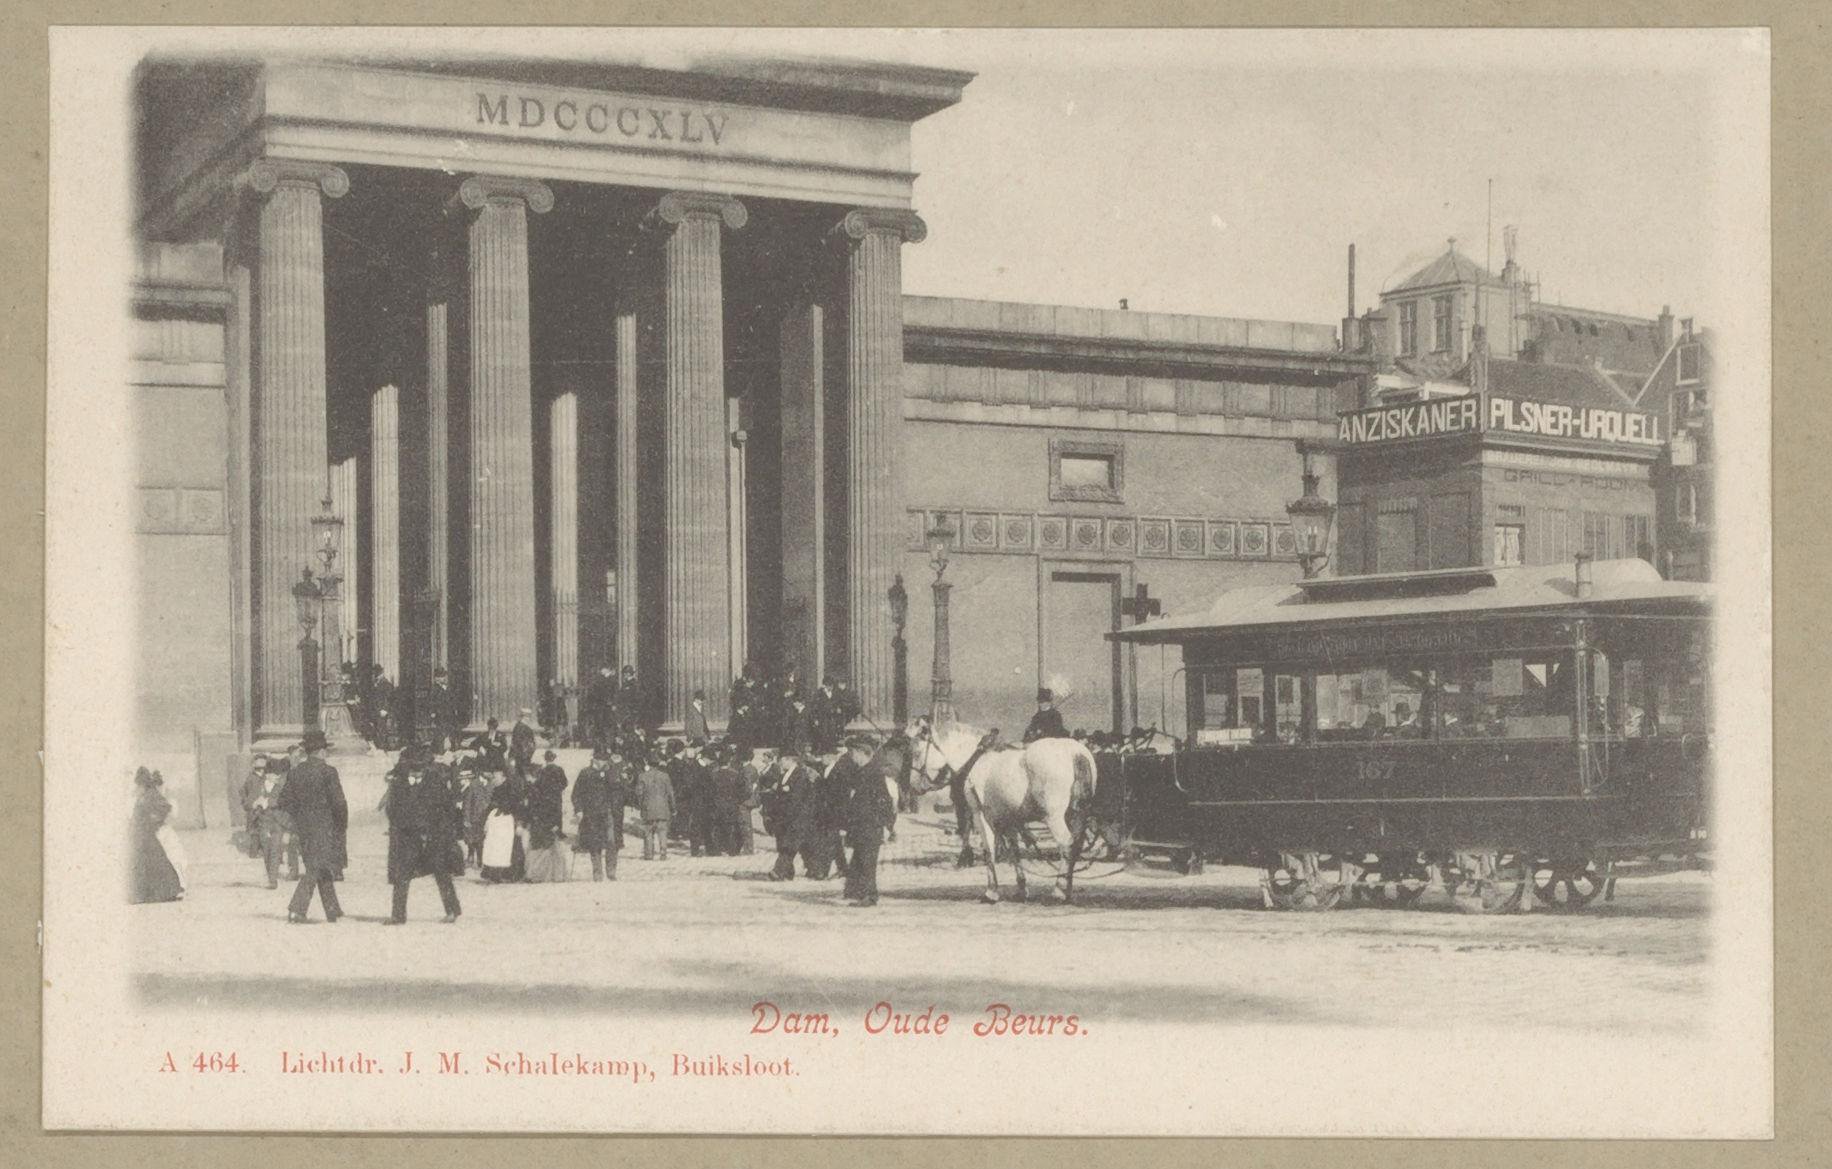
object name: photomechanical print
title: Gezicht op de Beurs van Zocher te Amsterdam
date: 1903-1905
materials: paper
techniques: photograph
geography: buiksloot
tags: diligence, omnibus, horse-tram, stock exchange, stock-market, square, place, circus, etc. (+ city(-scape) with figures, staffage)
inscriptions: collector's mark: Lugt 1641b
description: Onderwerpsrubriek binnen de Atlas Amsterdam: Handel en Zeevaart: Hulpbeurs op de Dam en Beurs (Dam).